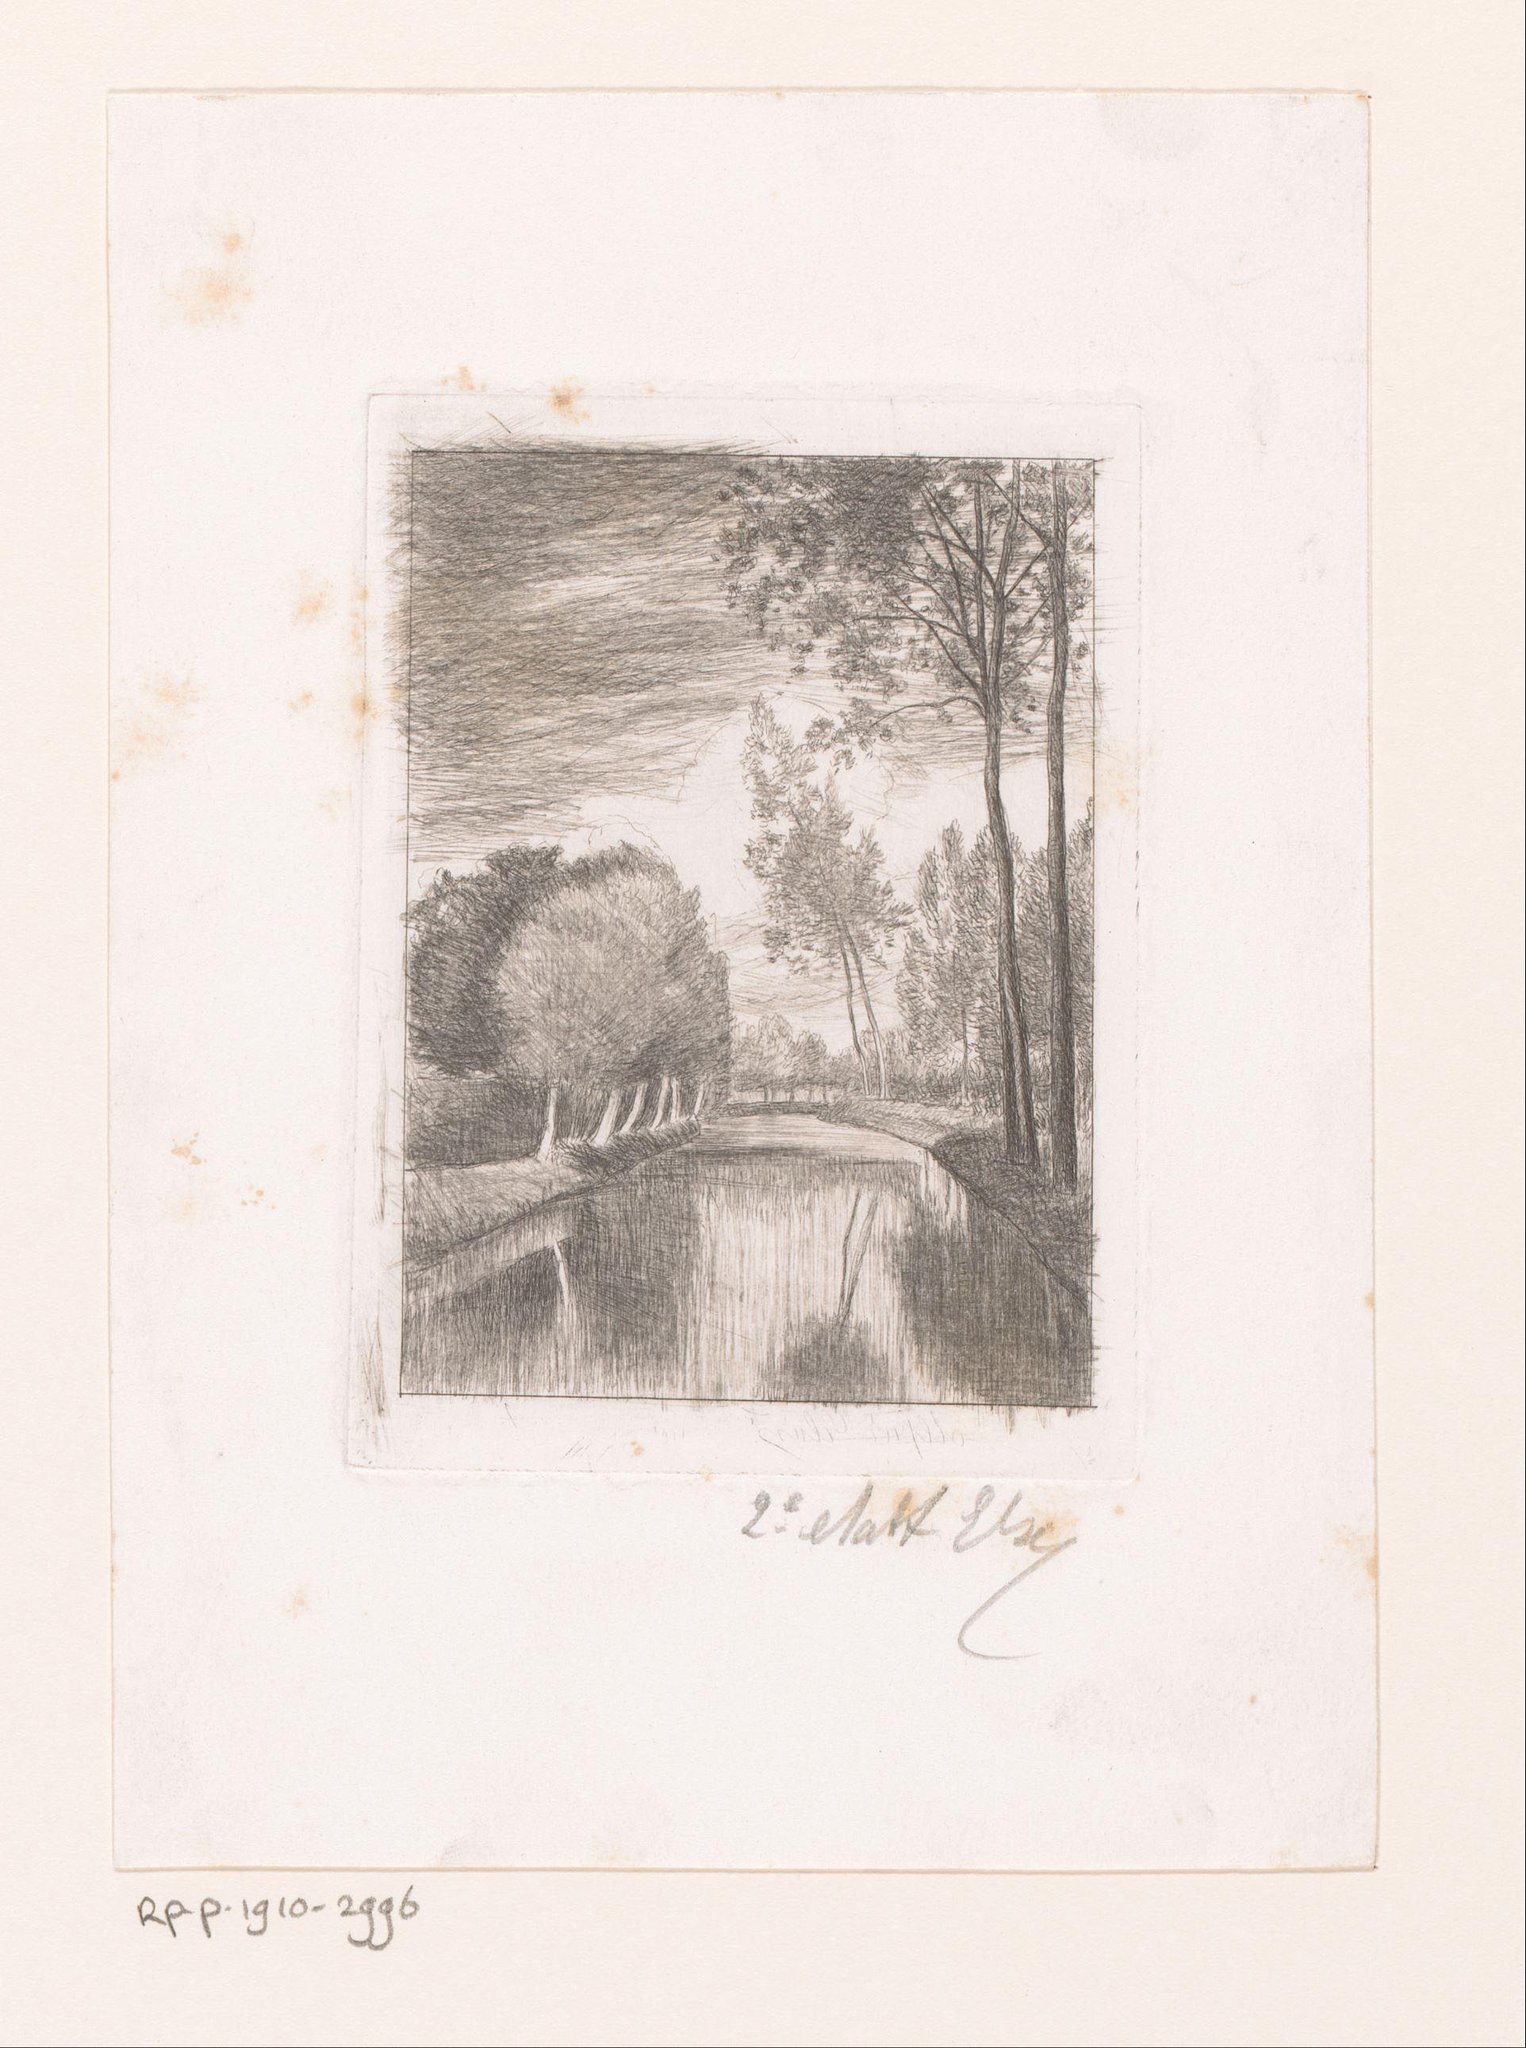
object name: print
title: Kanaal met begroeiing langs de oevers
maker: alfred elsen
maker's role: painter, print maker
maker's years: 1850-1914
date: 1860-1910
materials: paper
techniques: etching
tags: canal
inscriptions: collector's mark: Lugt 2228, inscription: ‘2e etat’